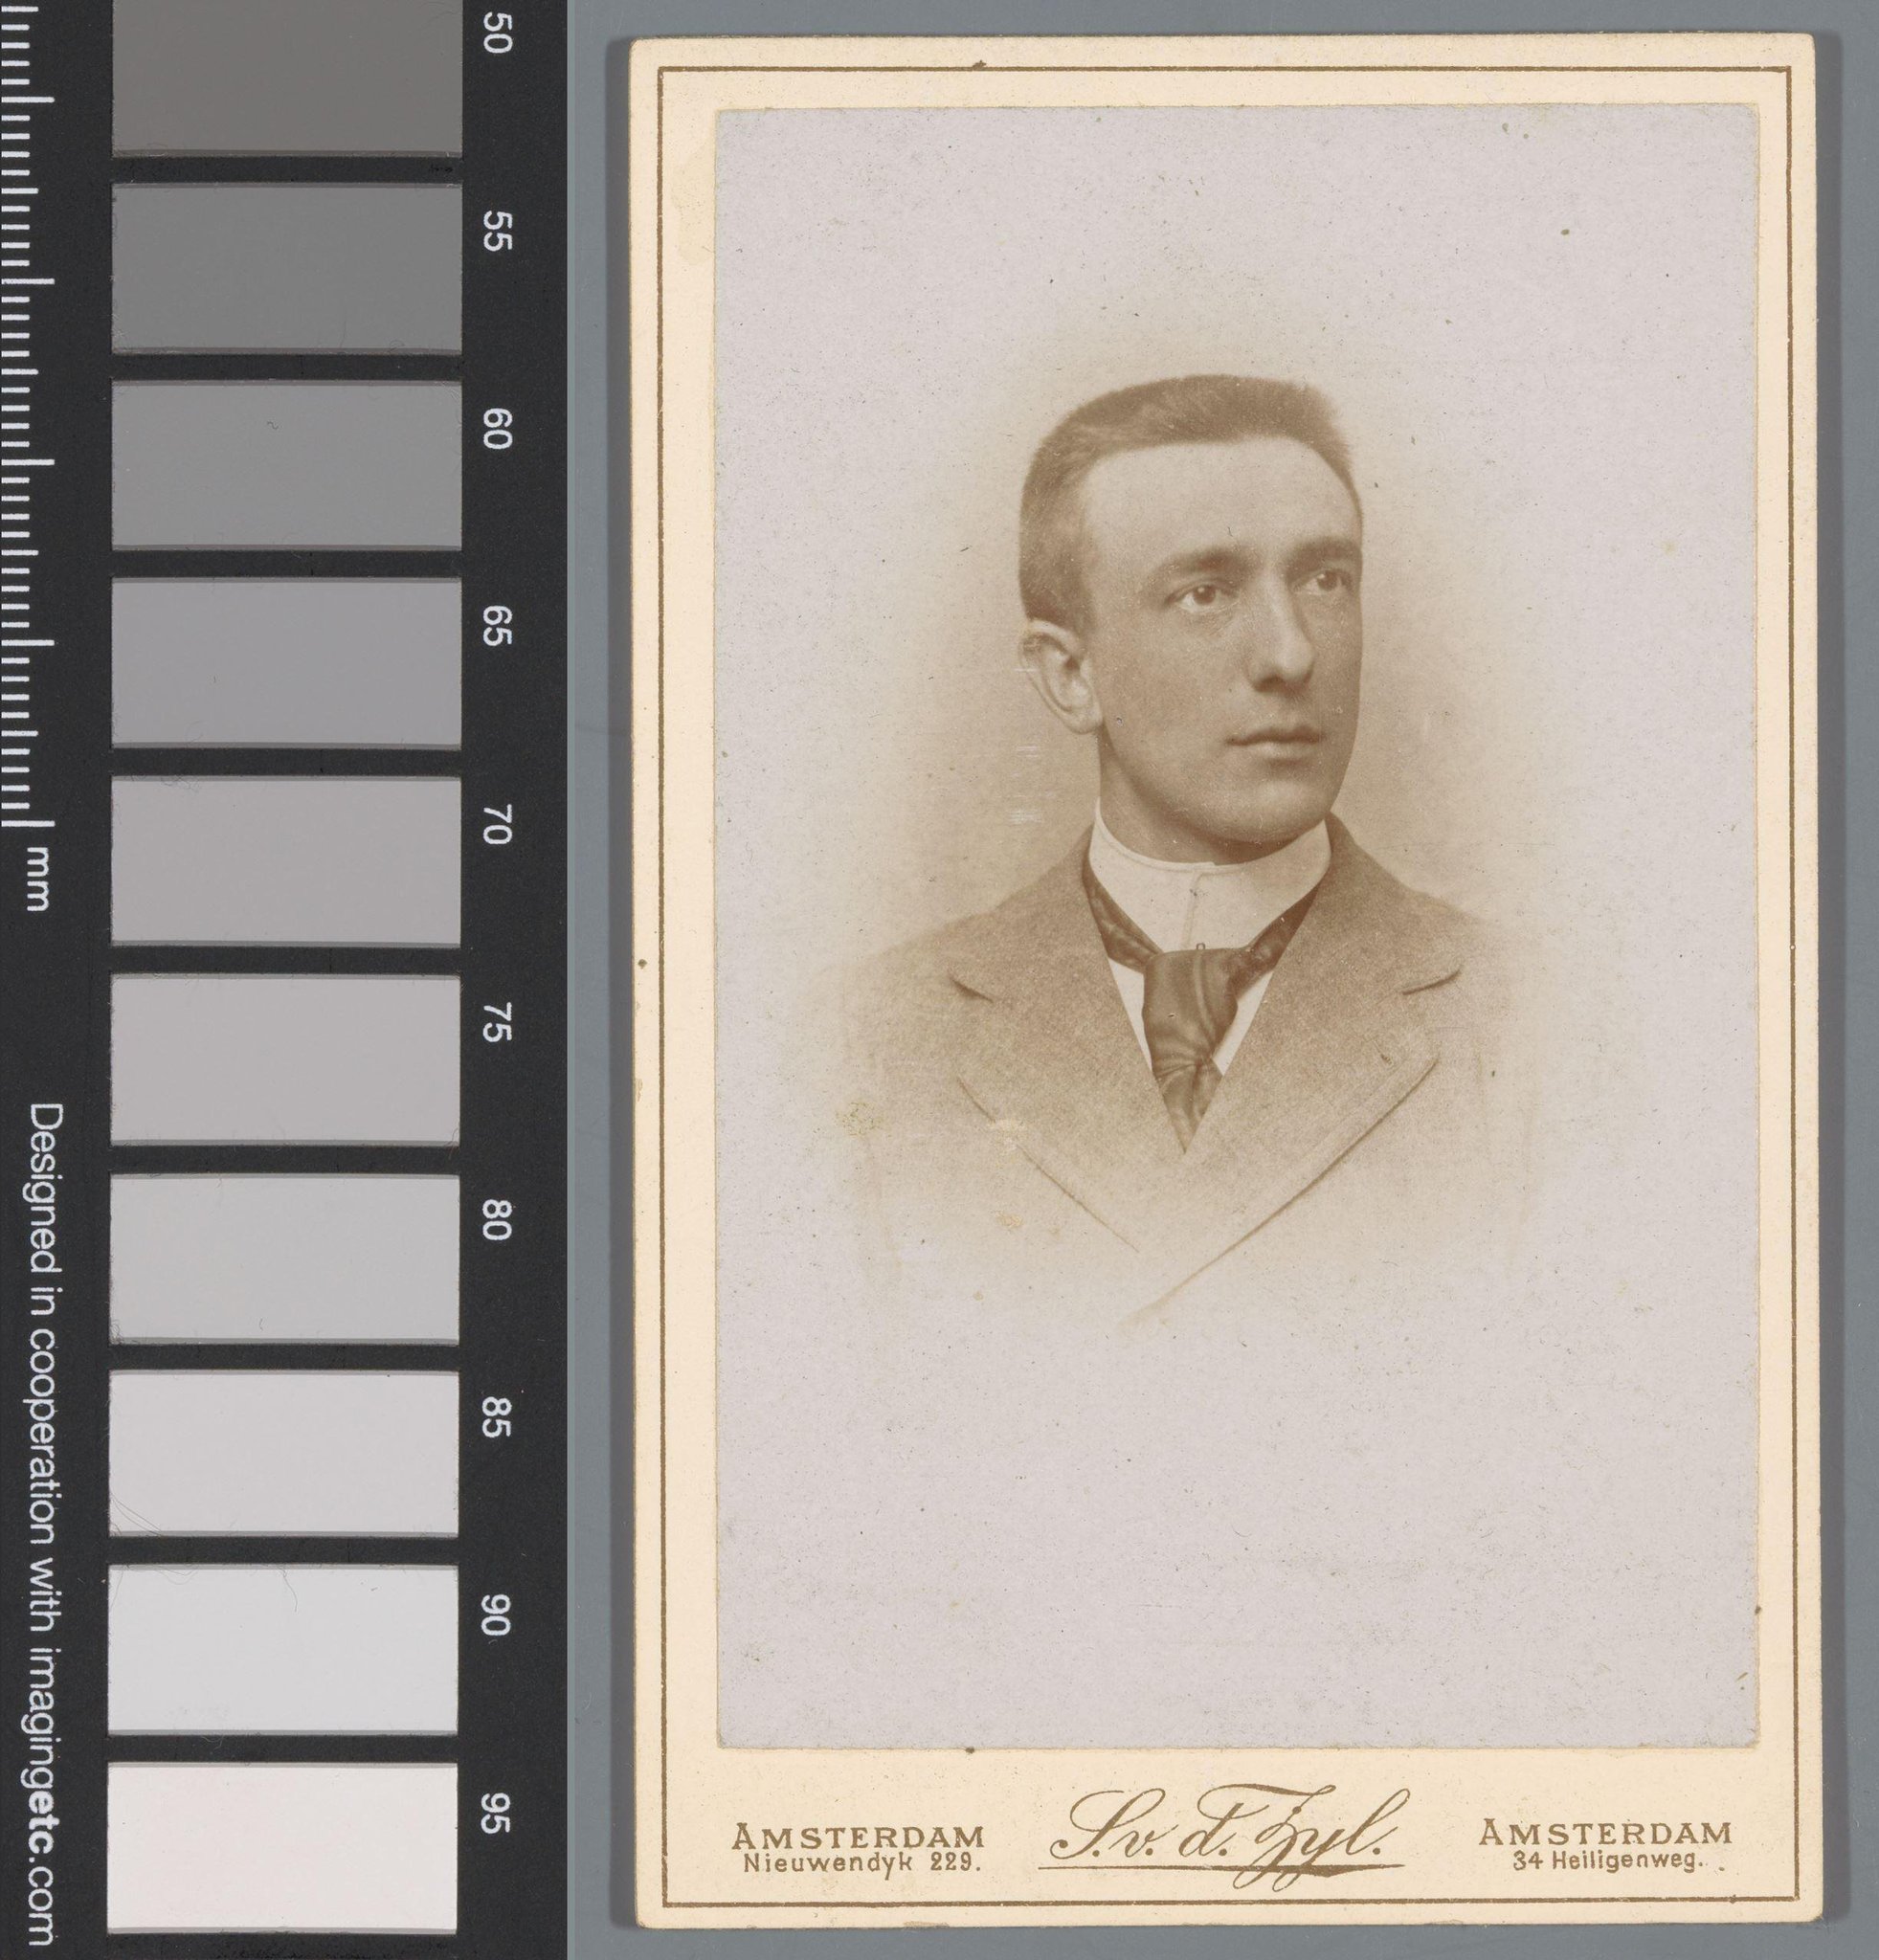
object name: carte de visite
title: Portret van een onbekende man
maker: sander van der zijl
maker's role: fotograaf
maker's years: 1852-1935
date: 1888-1895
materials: paper, cardboard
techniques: gelatin silver print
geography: amsterdam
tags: adult man, anonymous historical person portrayed, amsterdam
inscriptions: inscription: ‘Amsterdam/ Nieuwendyk 229./ S.v.d.Zijl./ Amsterdam/ 34 Heiligenweg.’, inscription: ‘Photographische Ateliers/ van/ Sander van der Zijl/ 229 Nieuwendijk b/d. Dam,/ 34 Heiligenweg hoek Handboogstraat/ Amsterdam/ De plaat blijft ter nabestelling bewaard./ Prager & Lojda, Berlin.’